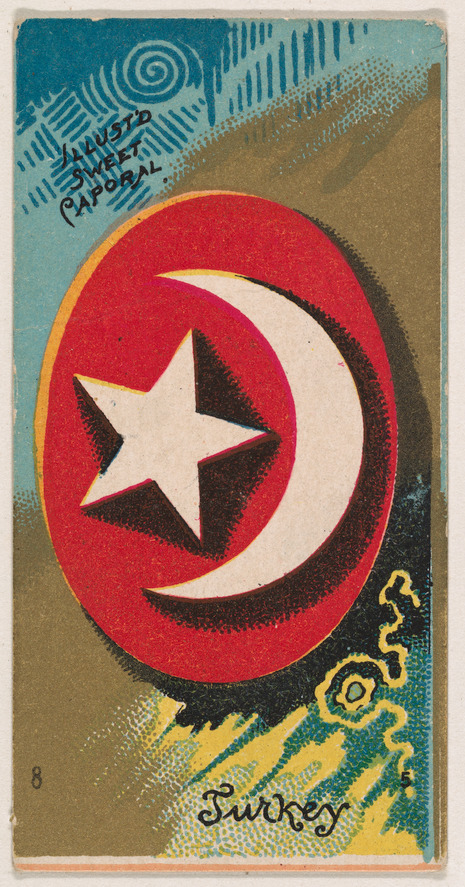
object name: print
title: Coat of Arms, Turkey, from the Military Series (N224) issued by Kinney Tobacco Company to promote Sweet Caporal Cigarettes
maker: kinney brothers tobacco company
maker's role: publisher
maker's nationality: american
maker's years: 1869-2011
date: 1888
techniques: color lithograph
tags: coat of arms